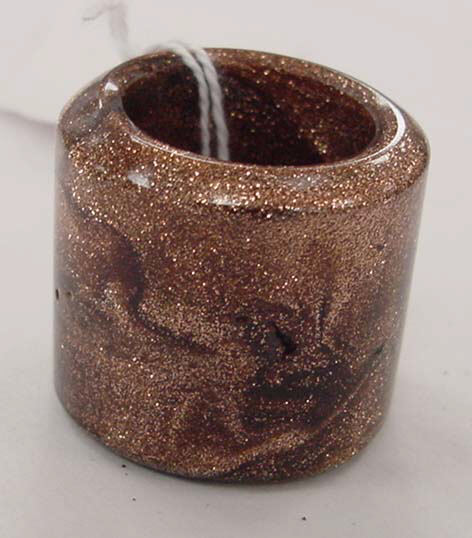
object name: ring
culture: chinese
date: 1801-1900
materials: stone